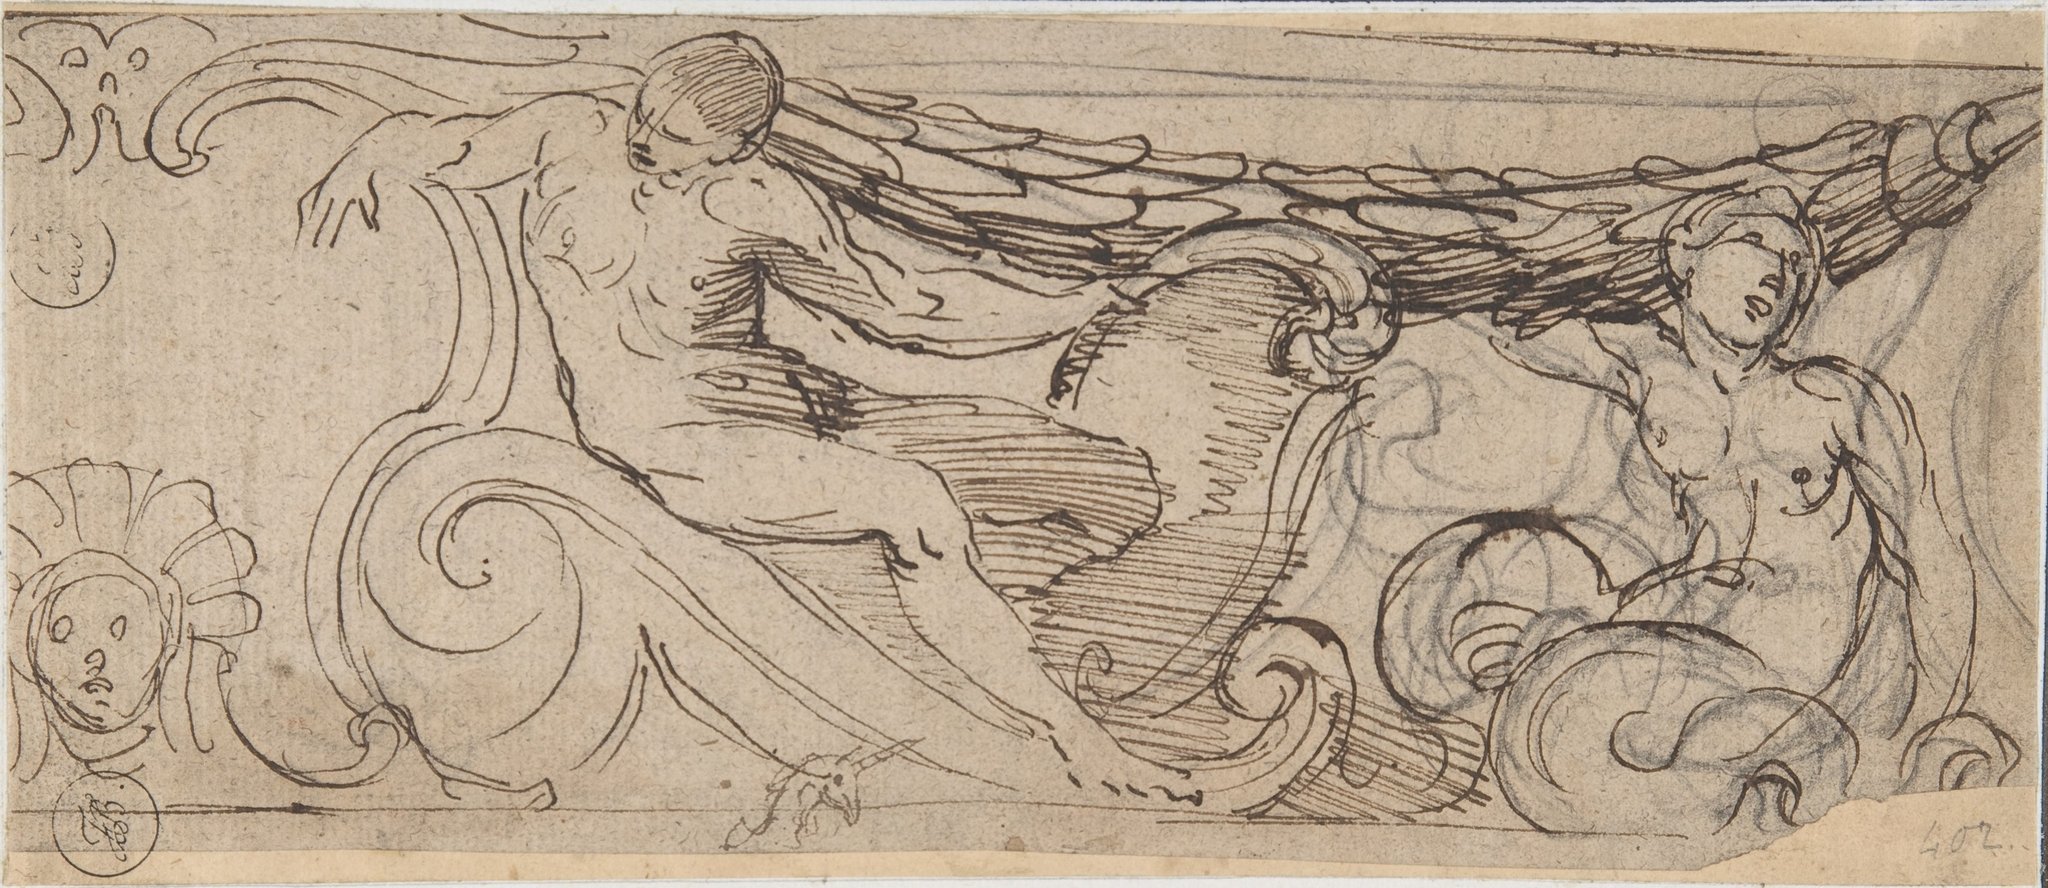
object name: drawing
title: Design for a Frieze: A Nude Man, Sea Creature, a Garland and Volutes, Small Head of Unicorn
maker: anonymous, italian, roman-bolognese, 17th century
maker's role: artist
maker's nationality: italian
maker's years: 1600-1700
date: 1600-1630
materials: chalk, ink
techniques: pen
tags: garlands,male nudes,unicorns